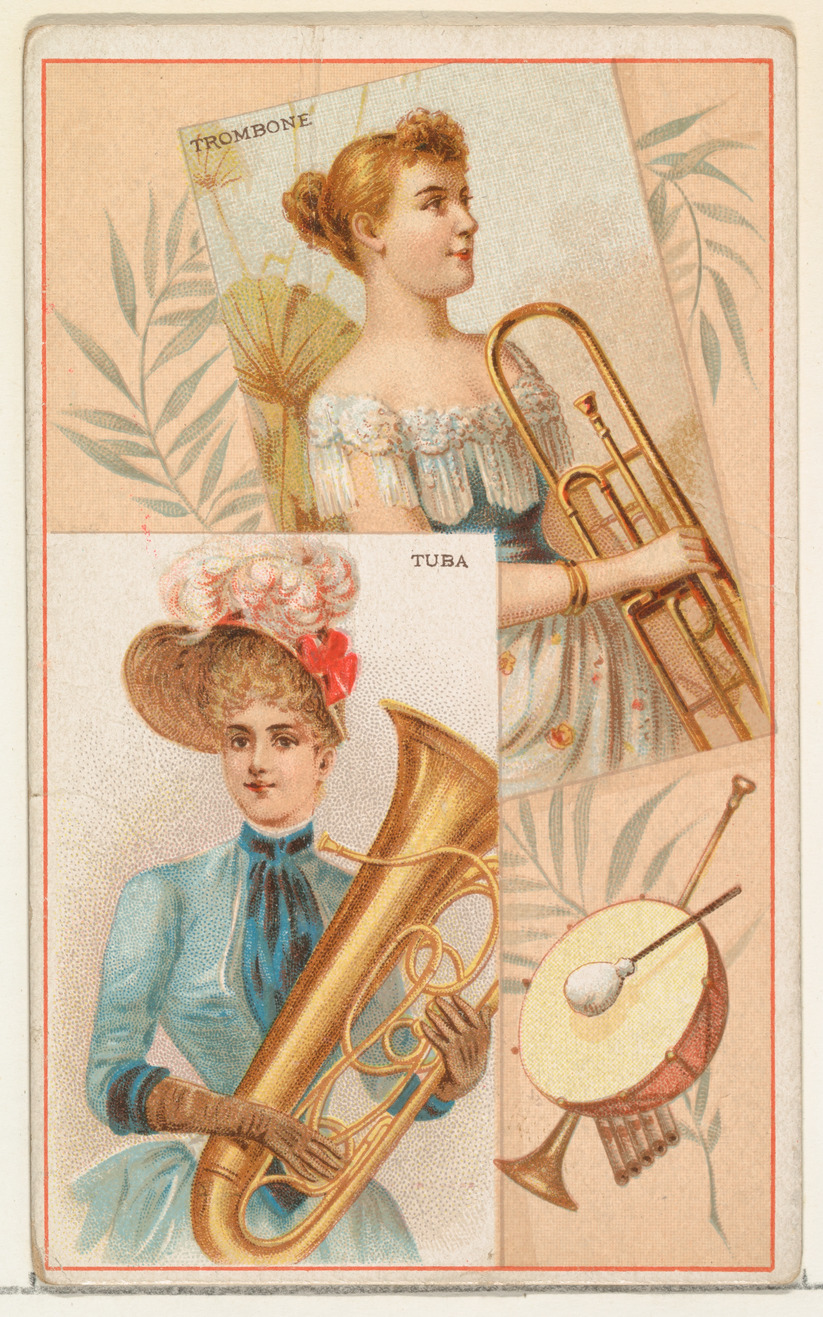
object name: print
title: Trombone and Tuba, from the Musical Instruments series (N121) issued by Duke Sons & Co. to promote Honest Long Cut Tobacco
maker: w. duke, sons & co.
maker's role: publisher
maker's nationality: american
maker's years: 1870-1920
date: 1888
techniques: color lithograph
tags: women,trombones